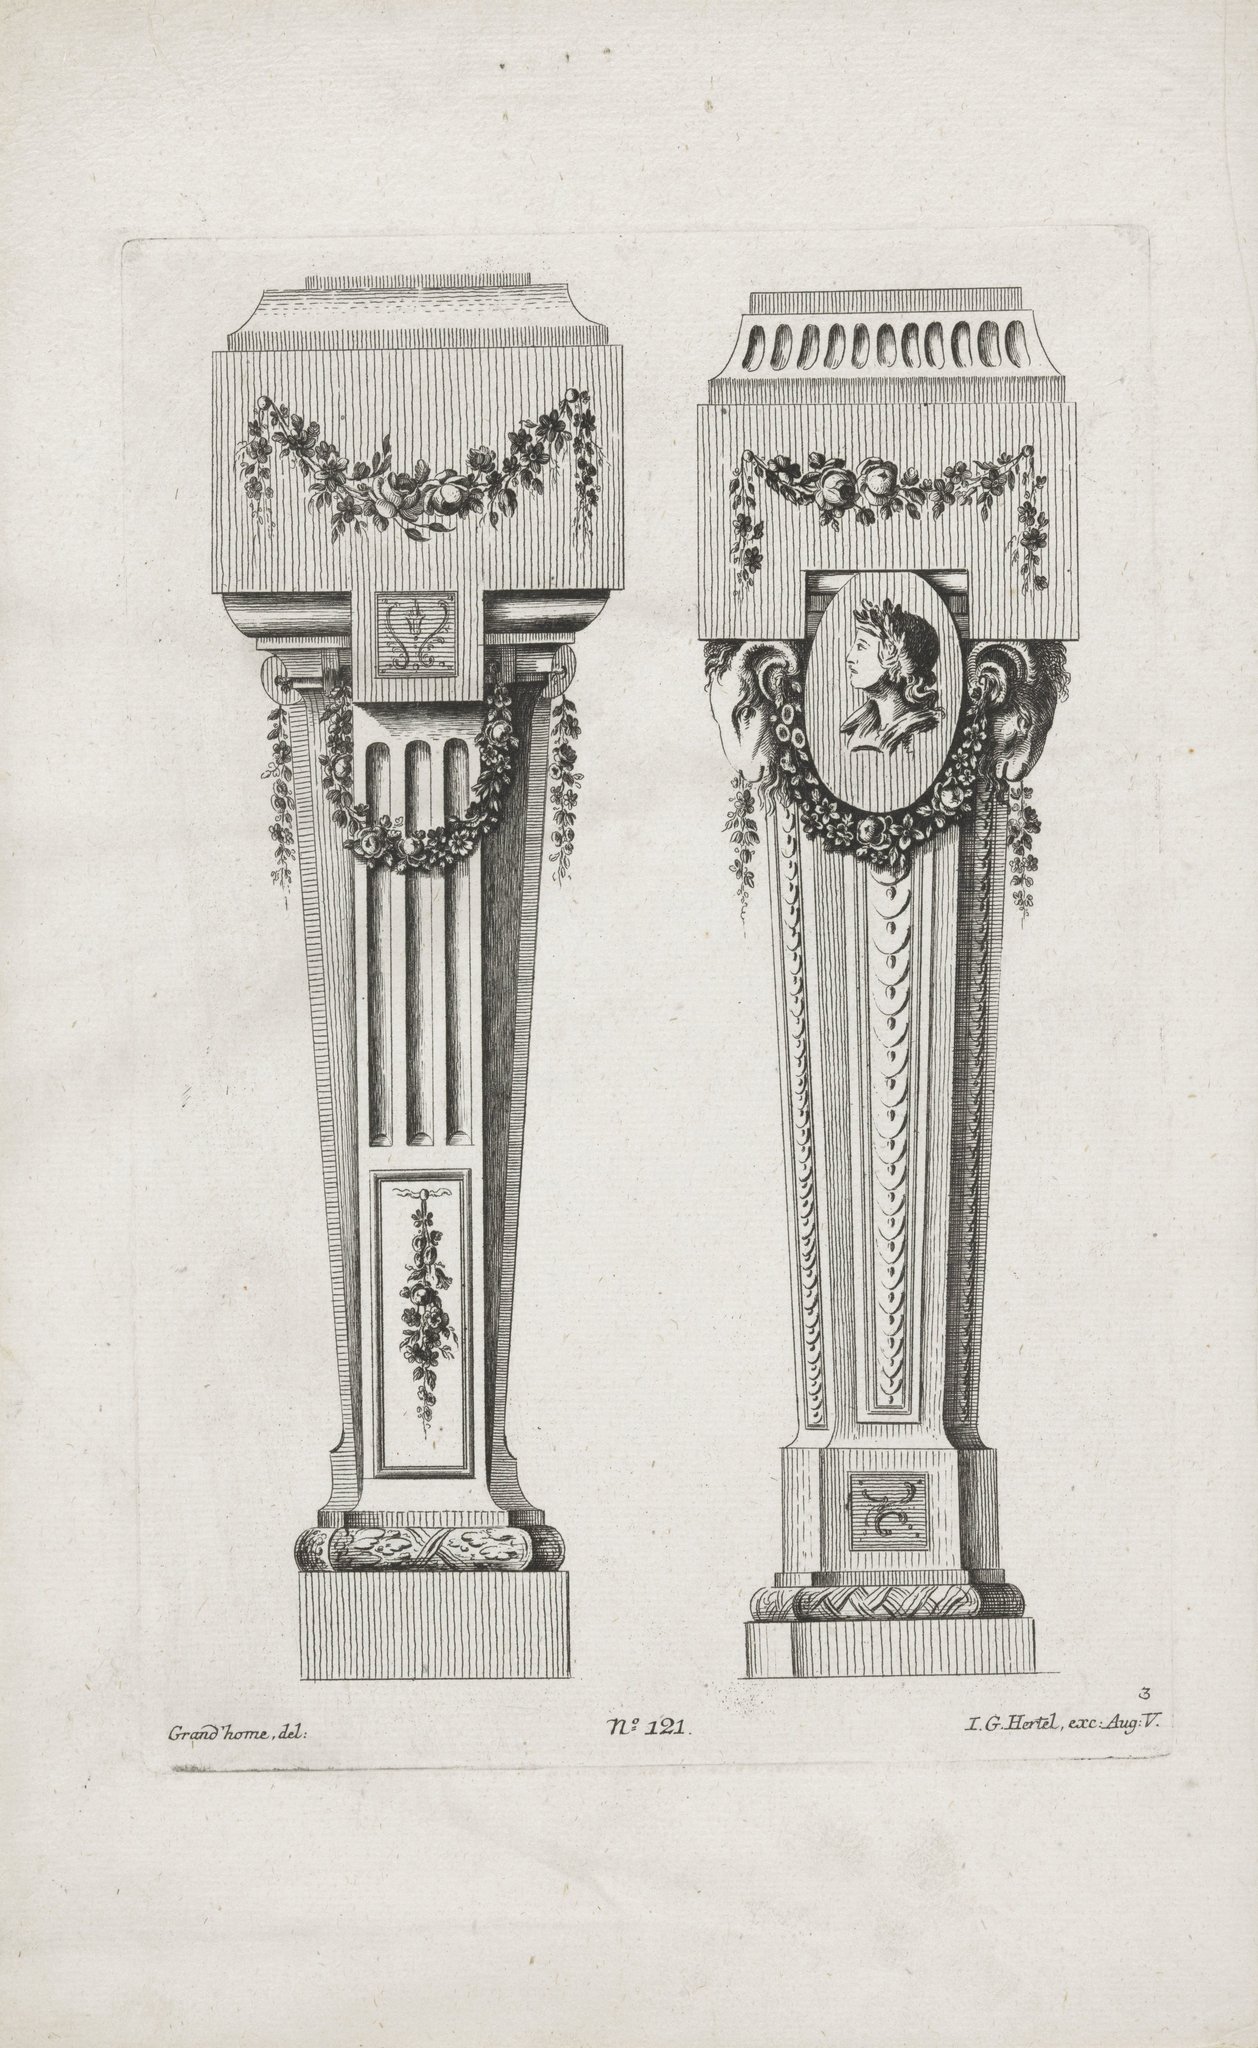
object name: print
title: Ontwerpen voor voetstukken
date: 1751-1775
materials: paper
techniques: etching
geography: augsburg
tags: goat (+ head of an animal), ornament ~ medallion, pedestal of a piece of sculpture (perhaps in the form of a herm)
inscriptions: collector's mark: Lugt 2228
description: Twee voetstukken met guirlandes. Het rechter voetstuk is gedecoreerd met bokkenkoppen en een ovaal medaillon met een persoon met lauwerkrans. Uitgeversnummer 121.